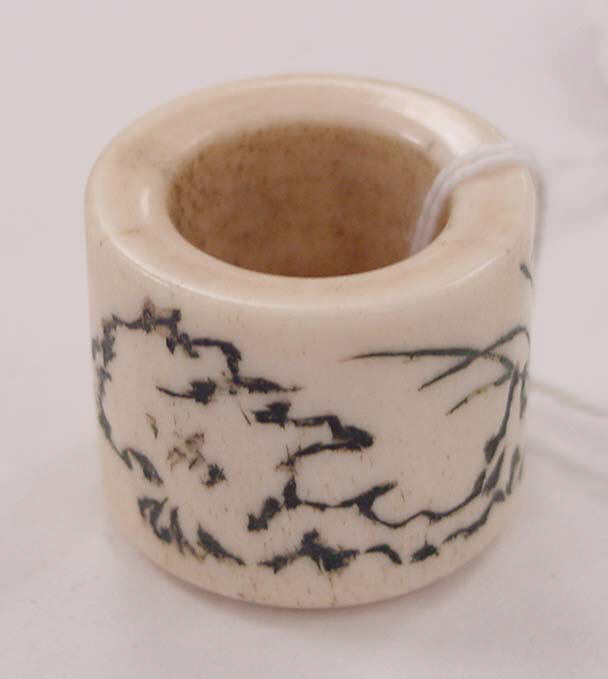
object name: ring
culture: chinese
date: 1801-1900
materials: ivory